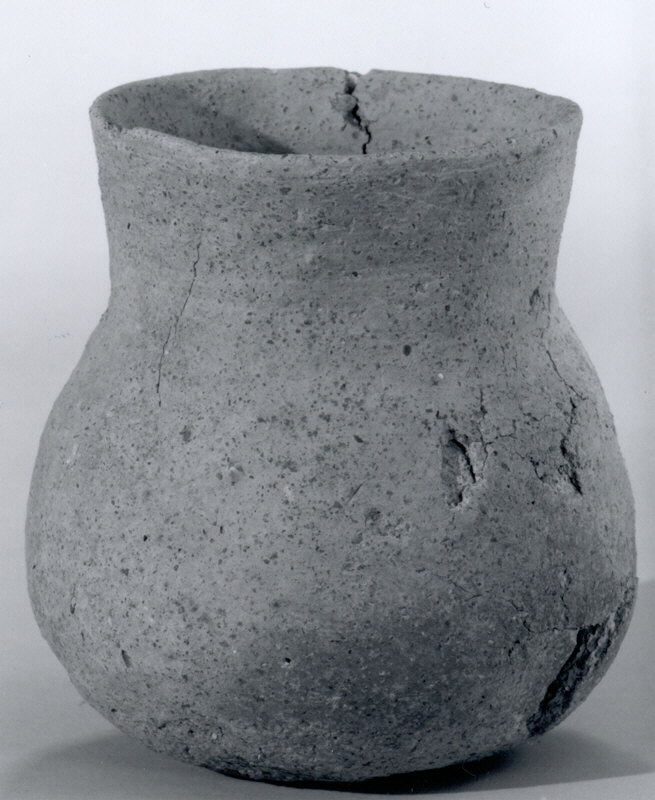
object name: jar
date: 3500-3300 BCE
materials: ceramic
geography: levant